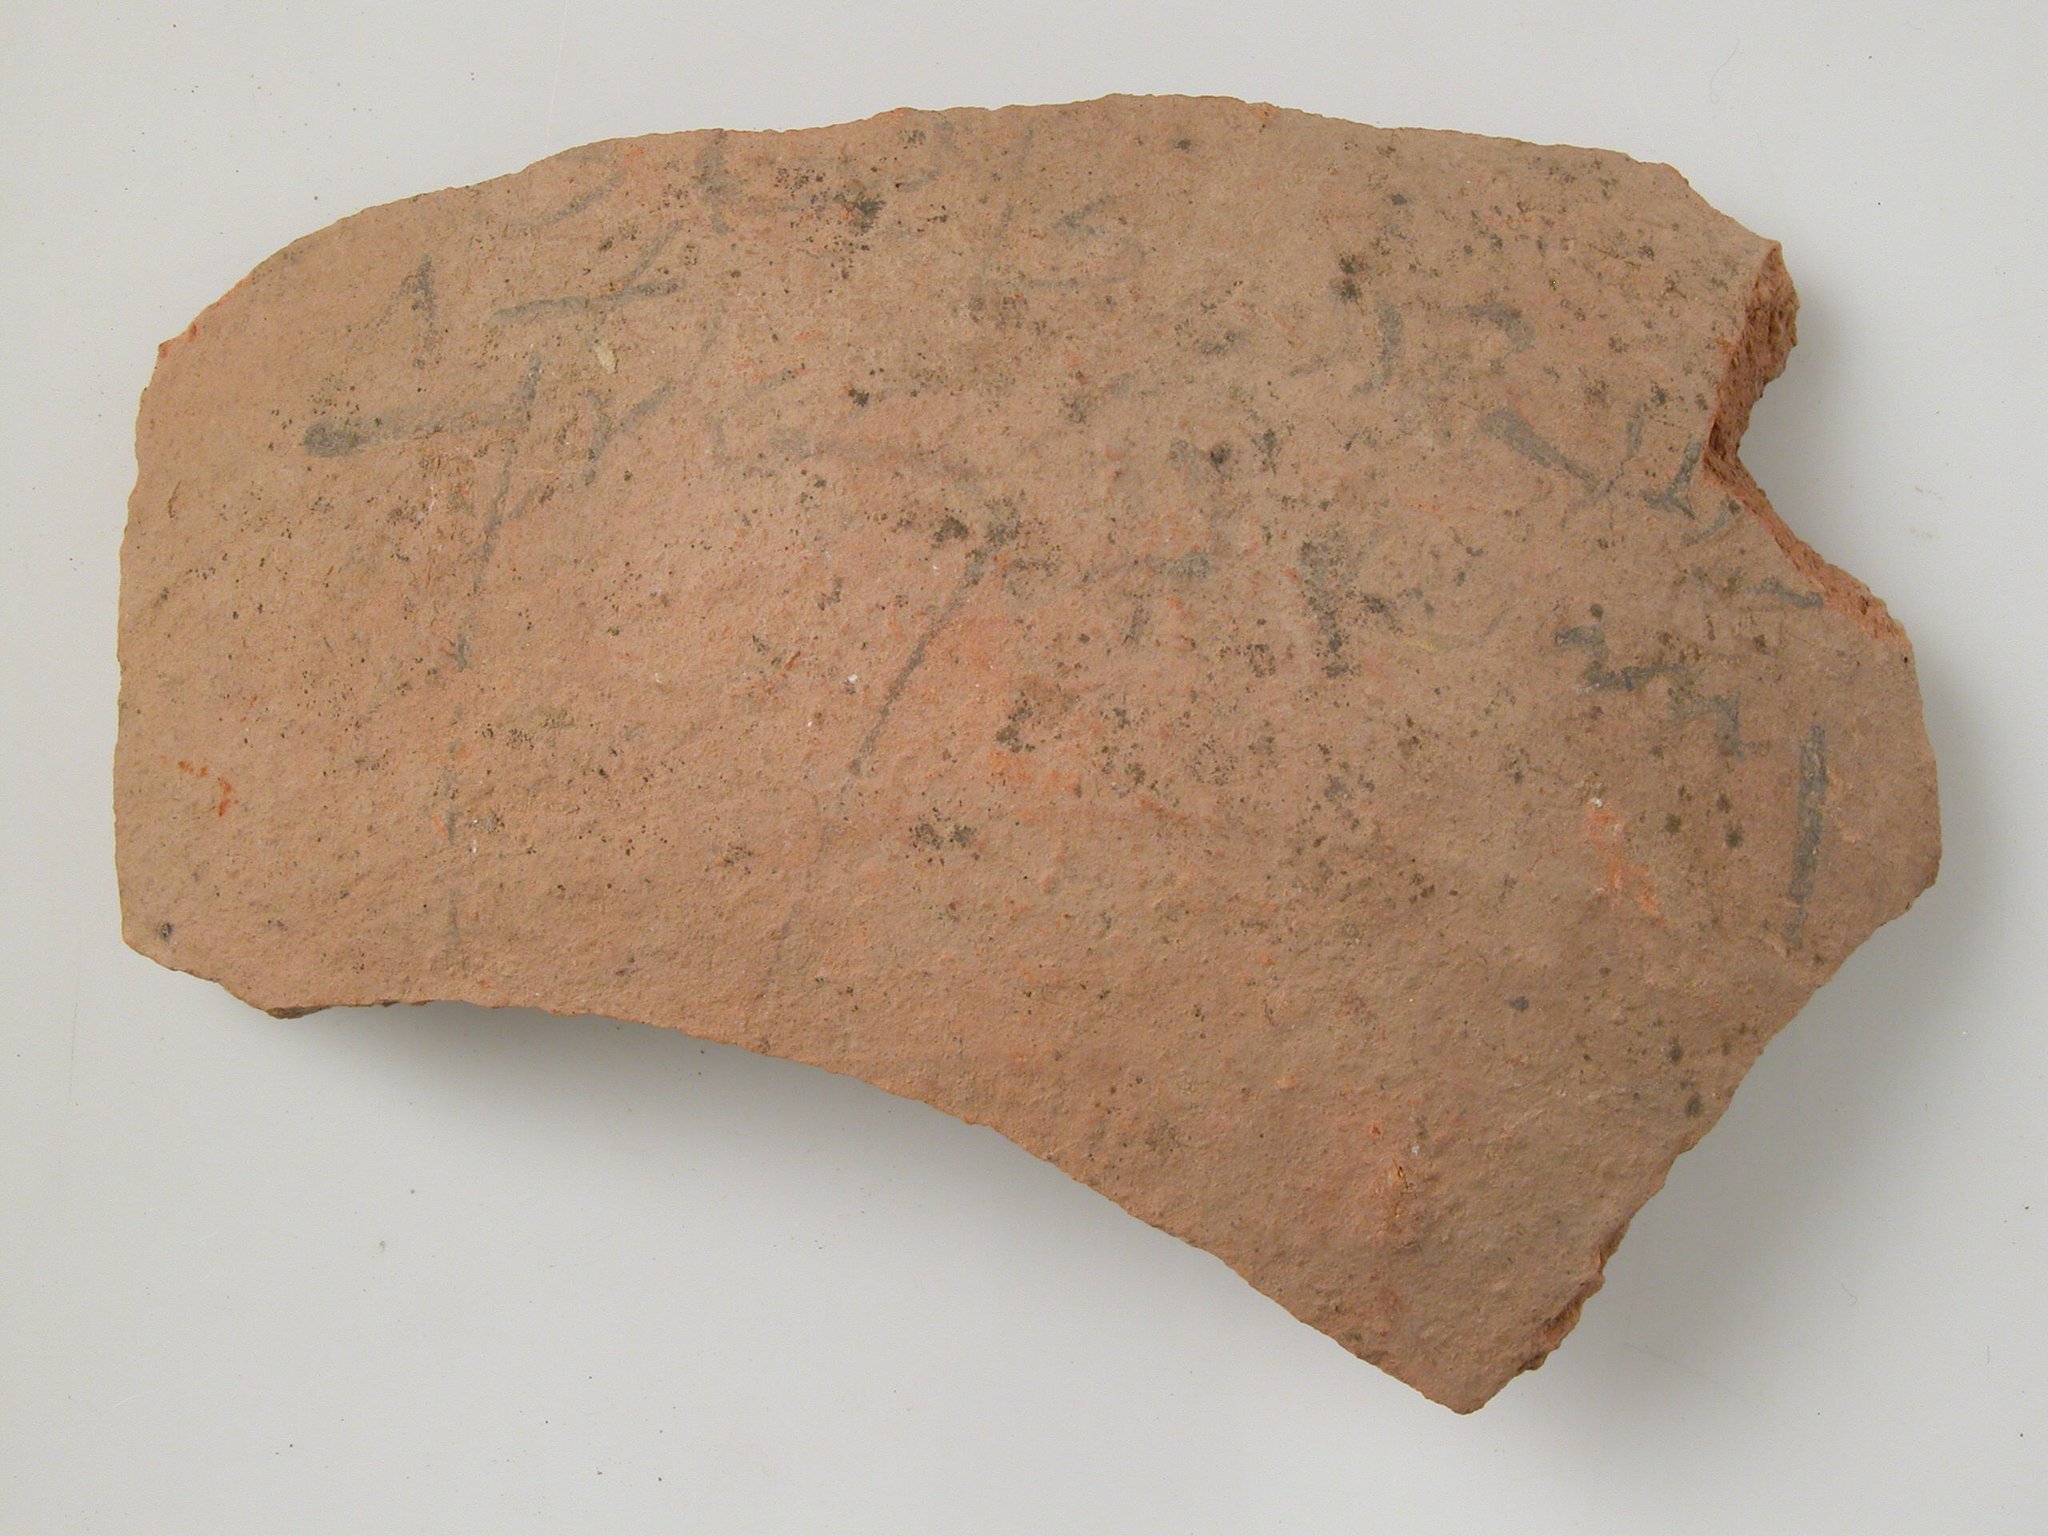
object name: ostracon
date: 595-530 BCE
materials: ink, pottery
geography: egypt